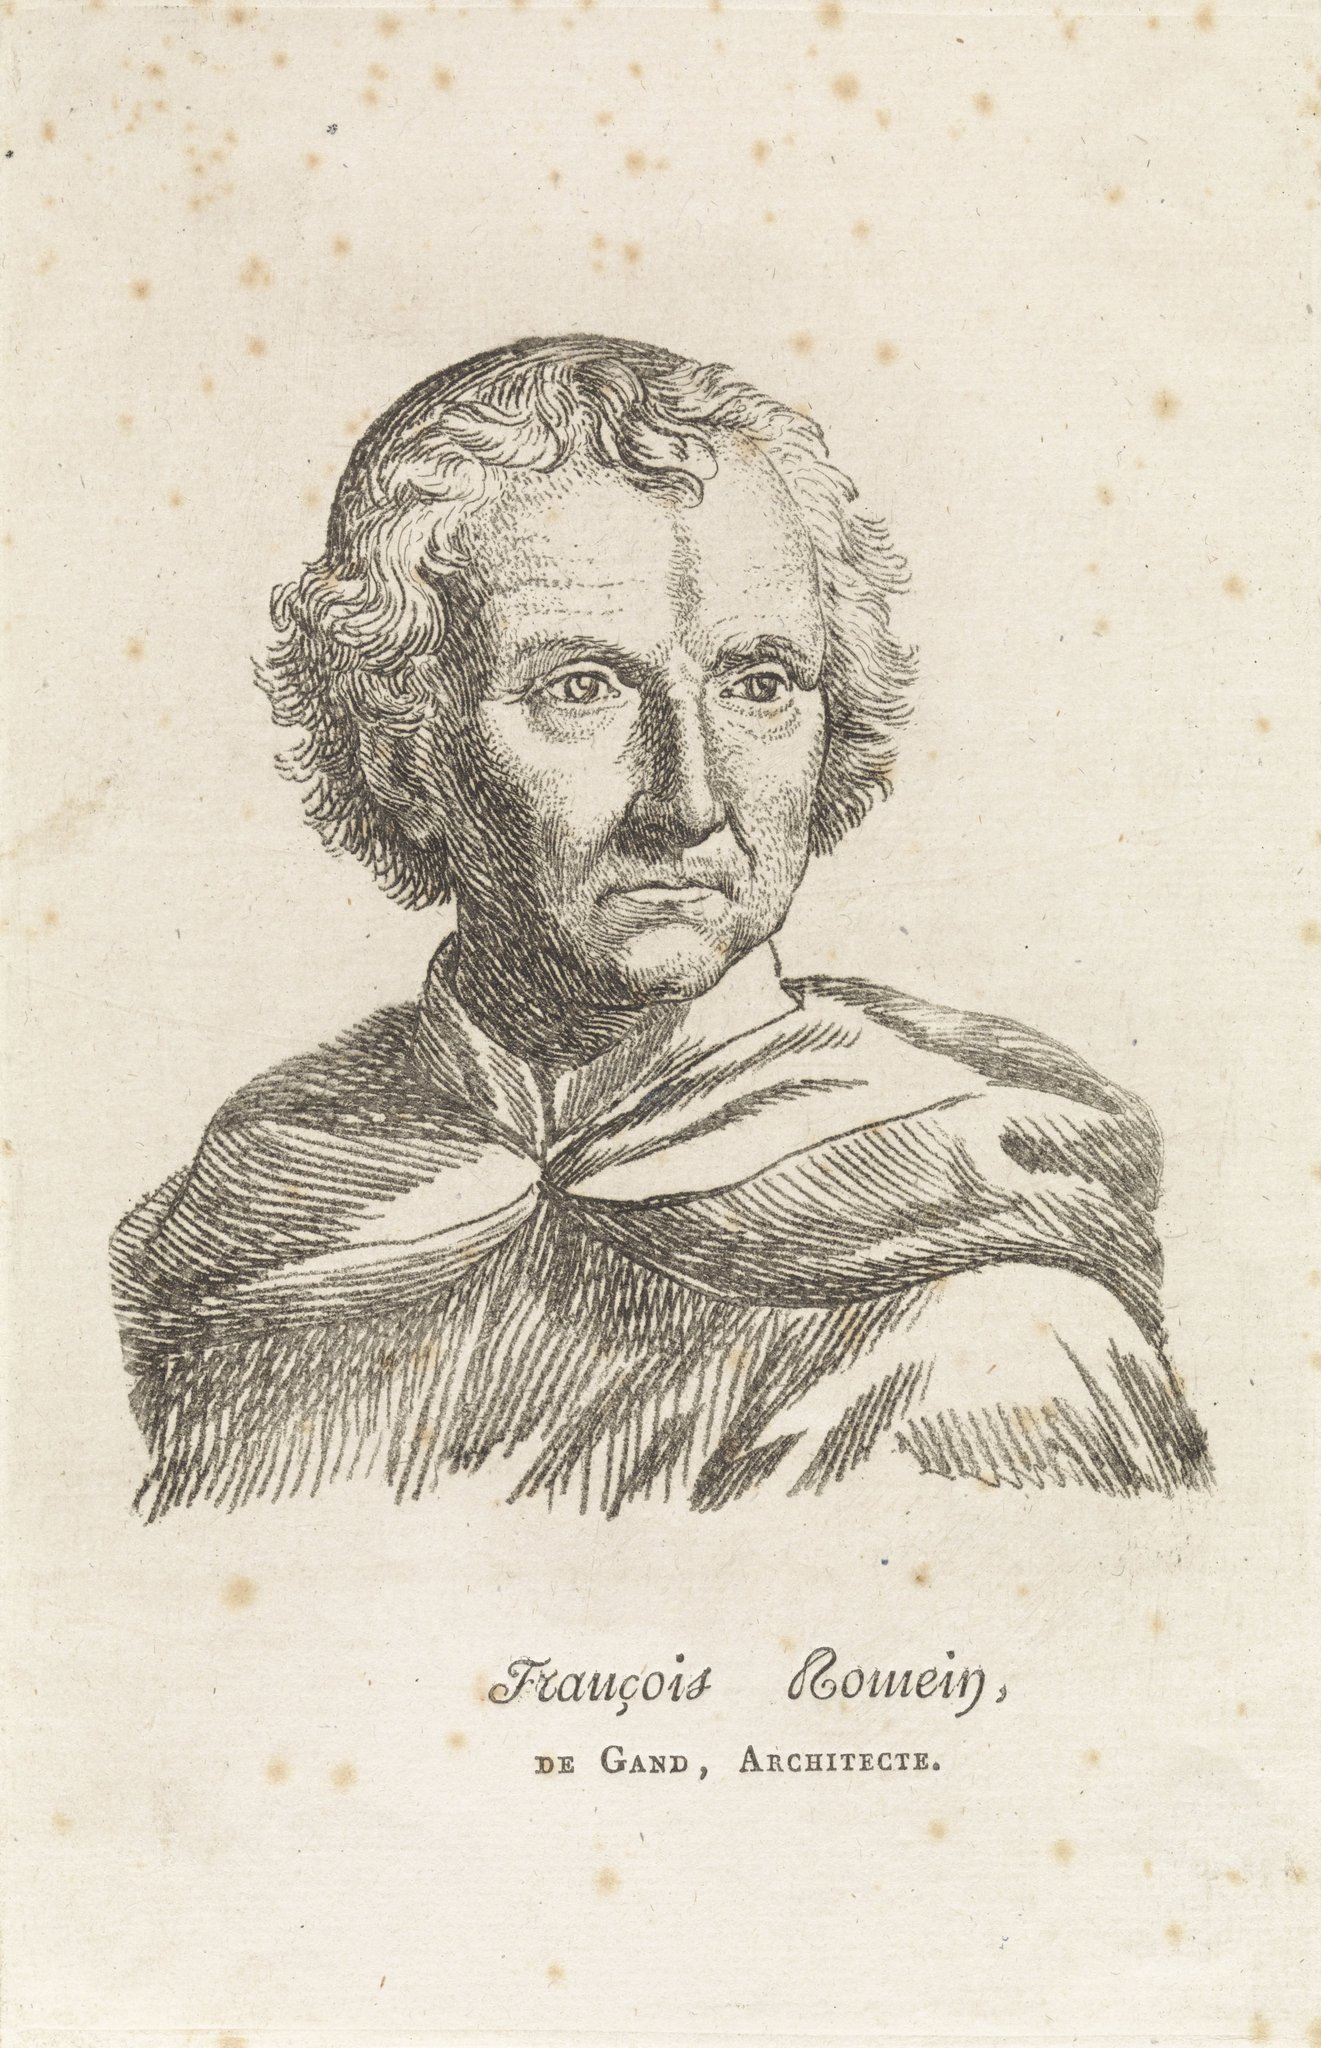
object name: print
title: Portret van François Romain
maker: philippe lambert joseph spruyt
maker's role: print maker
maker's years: 1727-1801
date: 1747-1801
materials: paper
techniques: etching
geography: ghent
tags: paris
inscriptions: collector's mark: Lugt 2228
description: Portret van François Romain, architect te Gent.